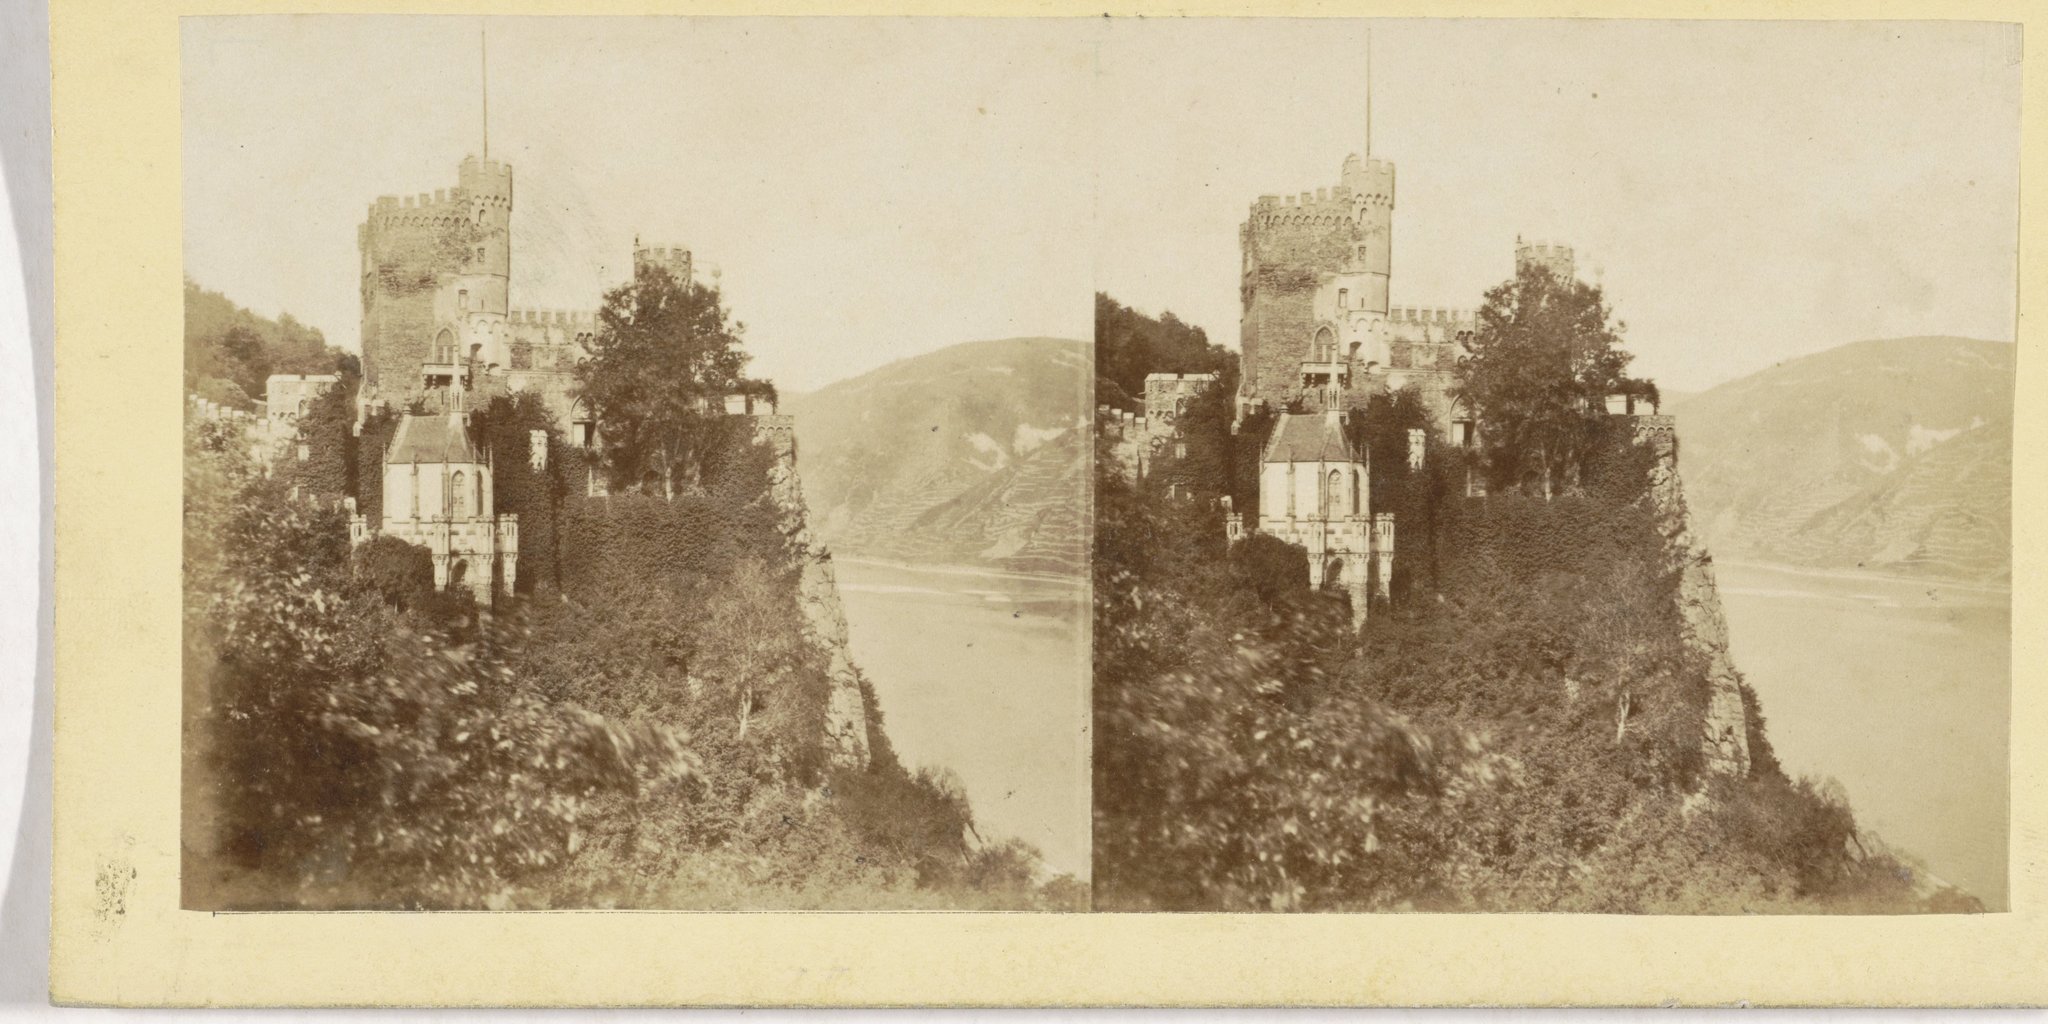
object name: stereograph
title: Gezicht op Burcht Klopp in Bingen aan de Rijn, Duitsland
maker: Anonymous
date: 1861-1870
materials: cardboard, paper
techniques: albumen print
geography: bingen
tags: landscape with tower or castle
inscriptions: inscription: ‘6’, number: ‘No 98’